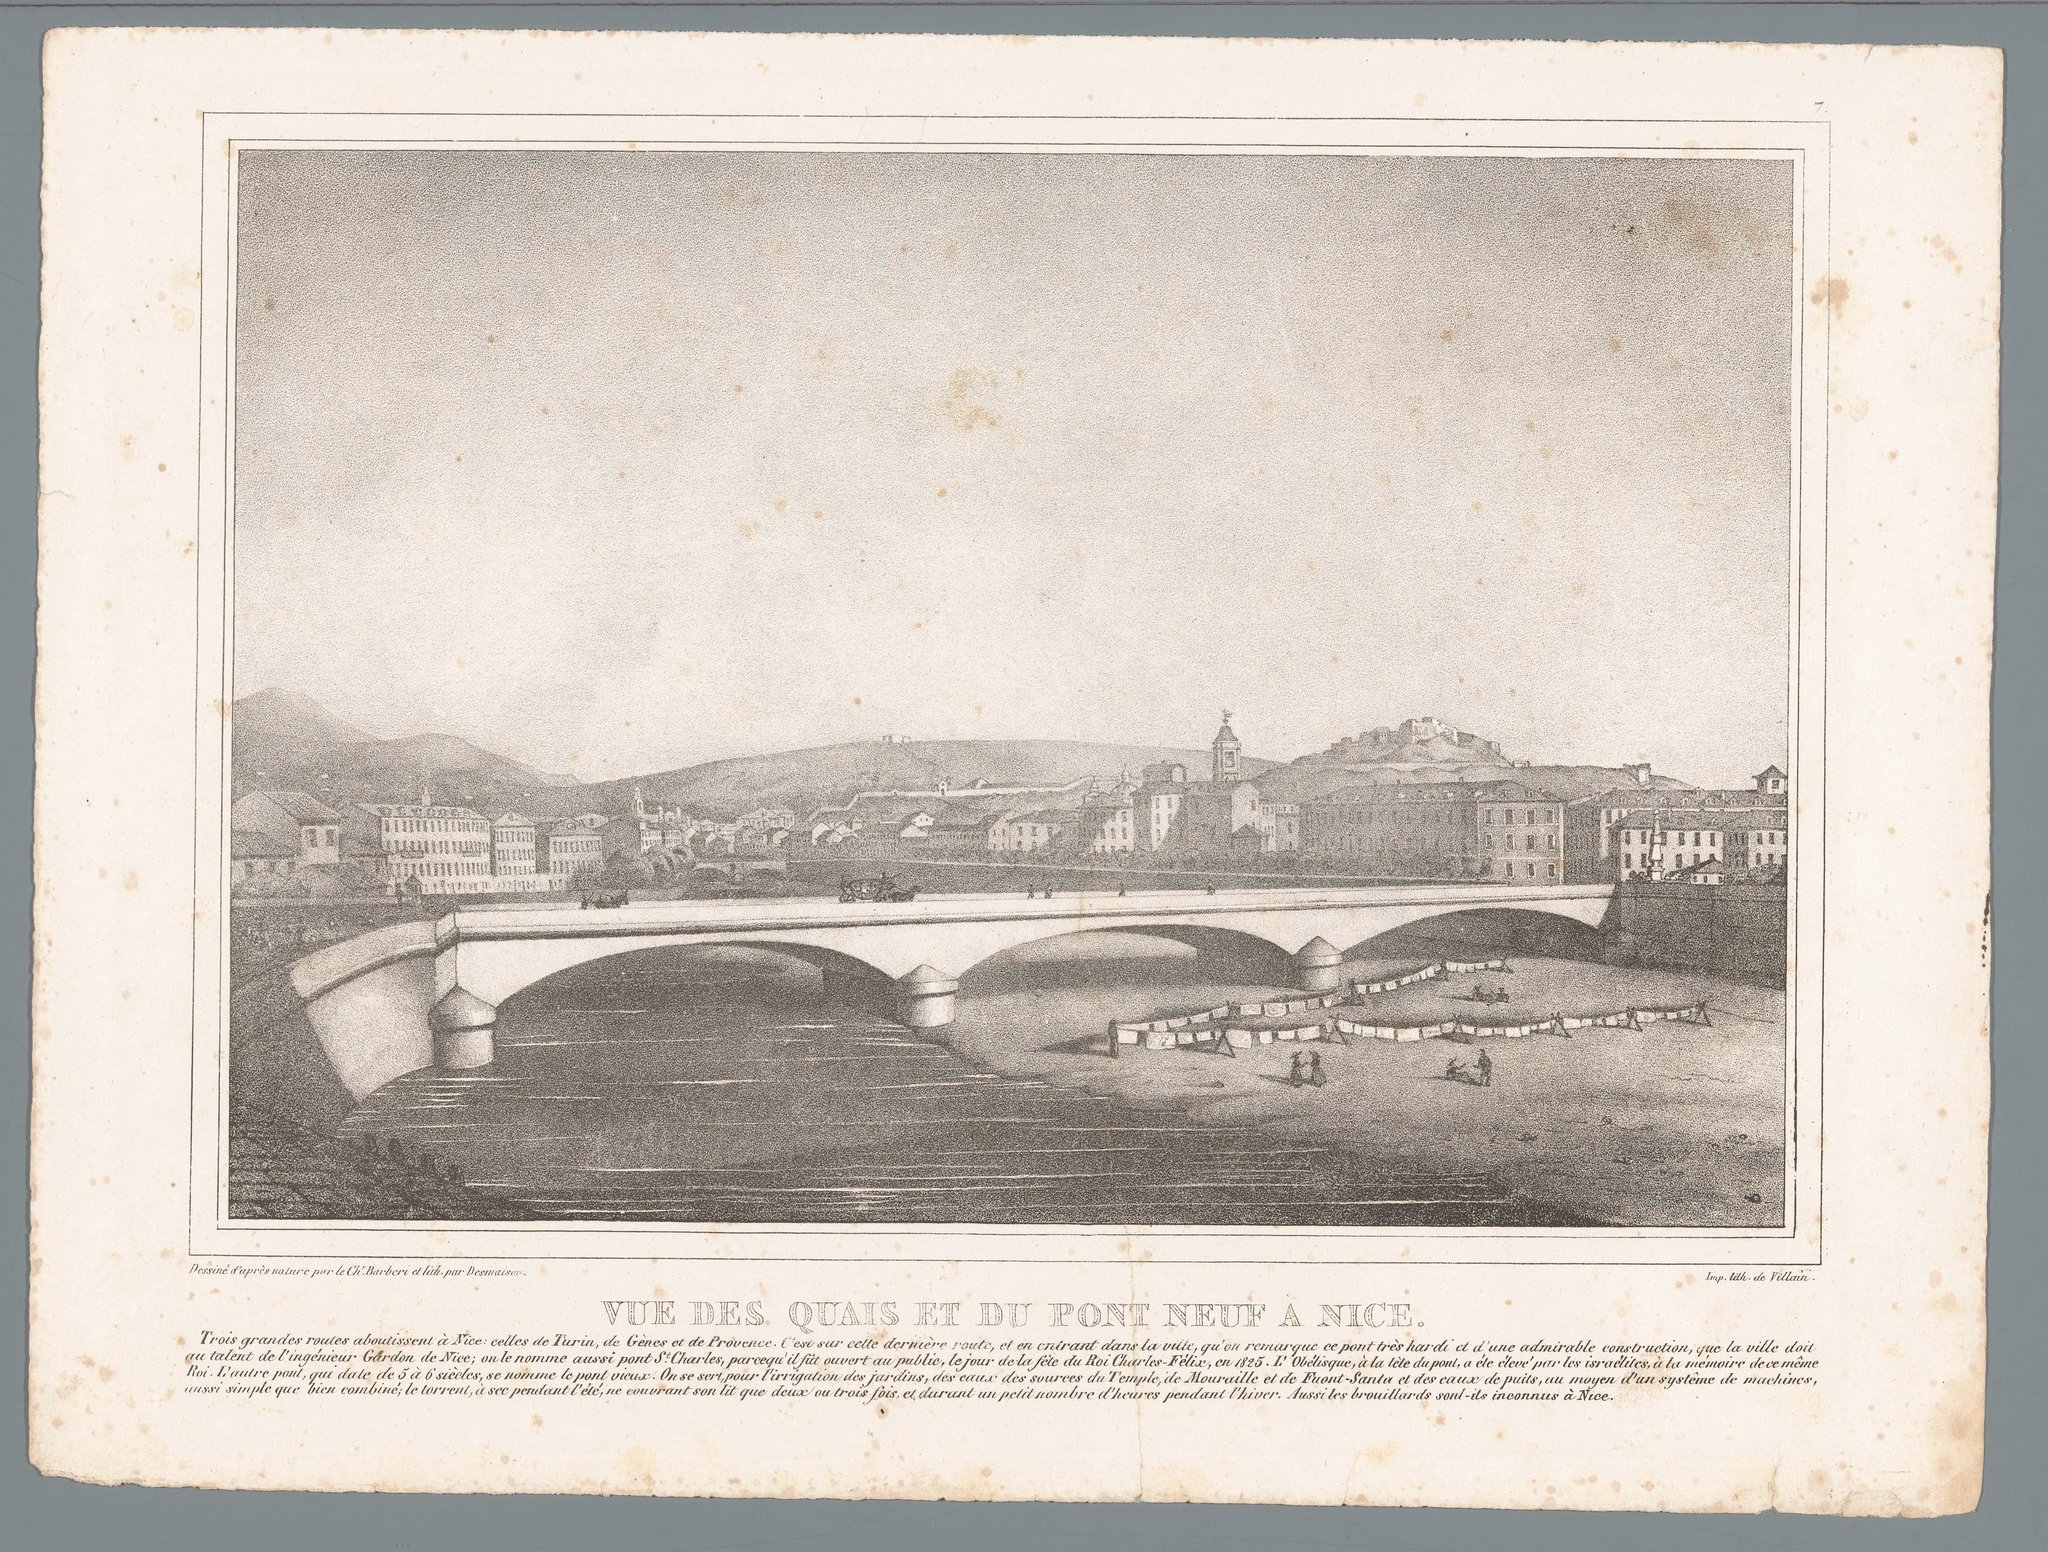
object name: print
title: Vue des quais et du Pont Neuf à Nice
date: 1834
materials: paper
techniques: lithograph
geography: paris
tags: bridge in city across river, canal, etc., city-view in general; 'veduta' (+ city(-scape) with figures, staffage)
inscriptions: collector's mark: Lugt 2228a